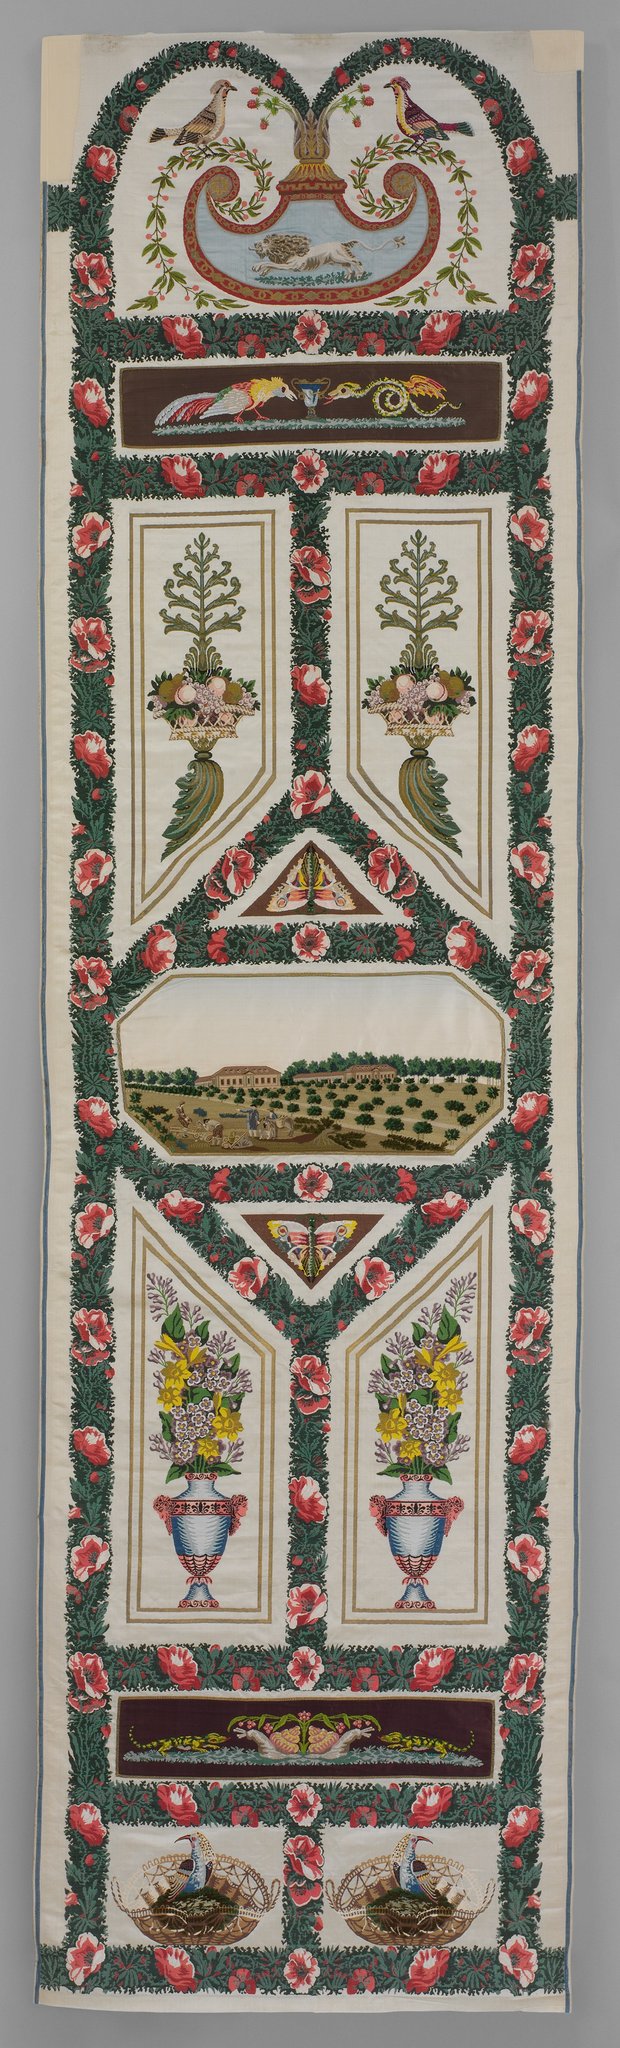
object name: wall hanging panel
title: Verdures du Vatican (set of two)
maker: jean démosthène dugourc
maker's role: designer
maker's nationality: french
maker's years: 1749-1825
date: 1799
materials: metal thread, silk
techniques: embroidery, weave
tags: birds,garlands,lions,lizards,poppies,landscapes